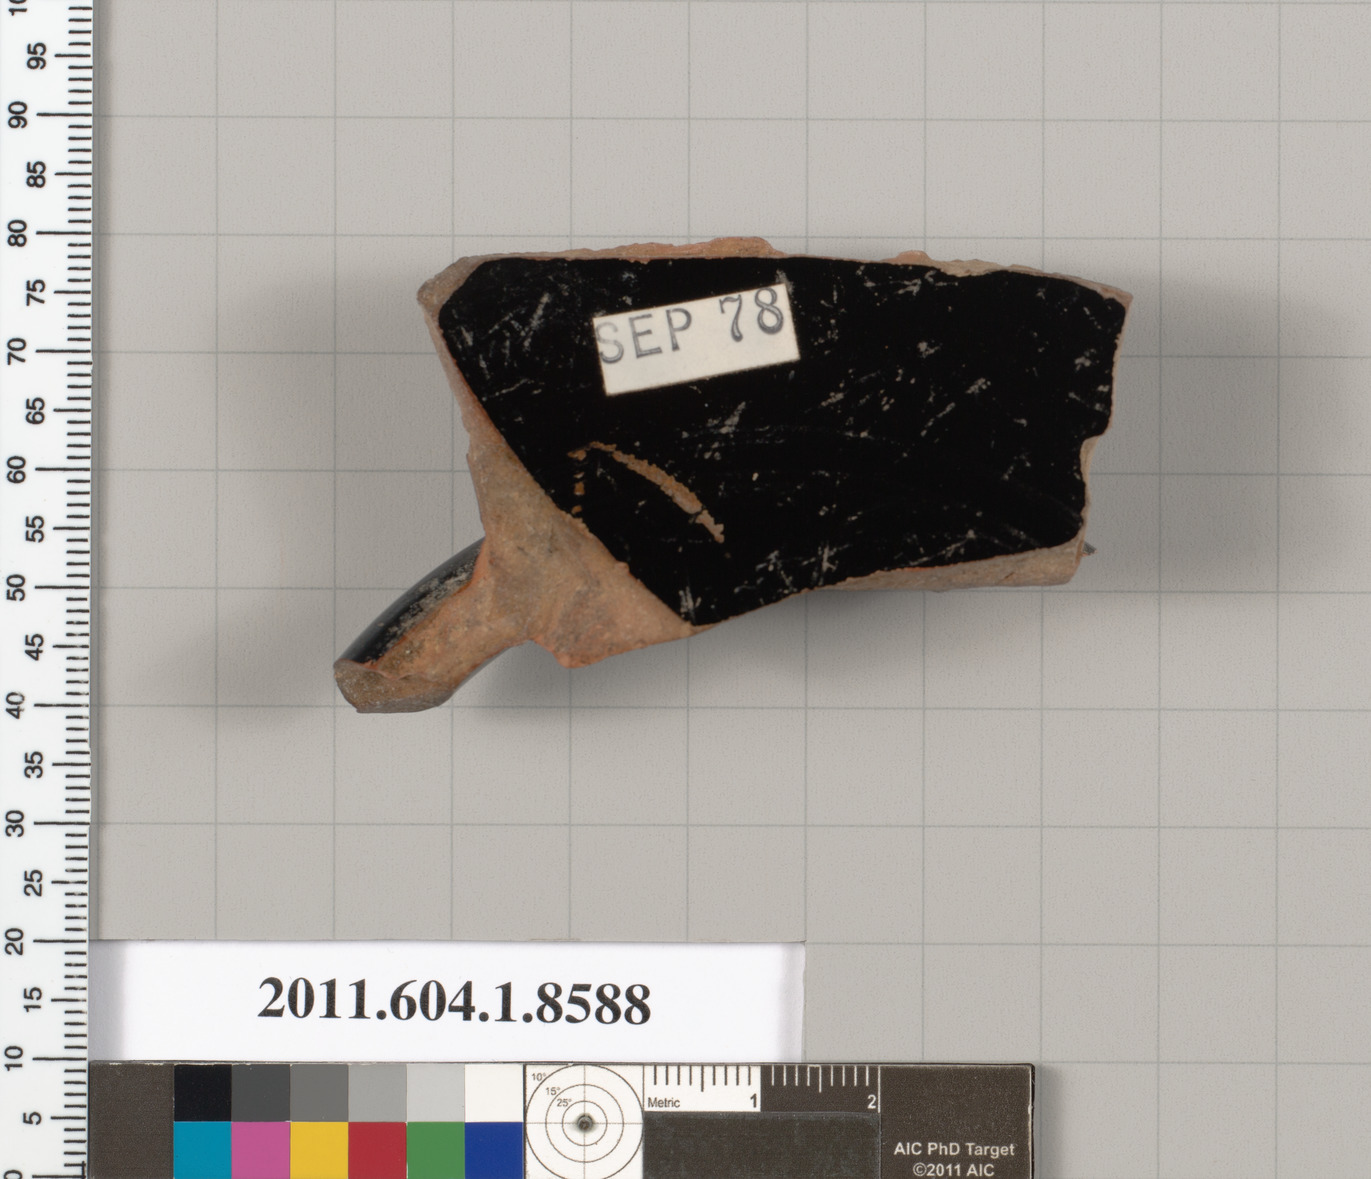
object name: kylix fragment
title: Terracotta fragment of a stemless kylix (drinking cup)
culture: greek, attic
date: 460-450 BCE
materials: terracotta